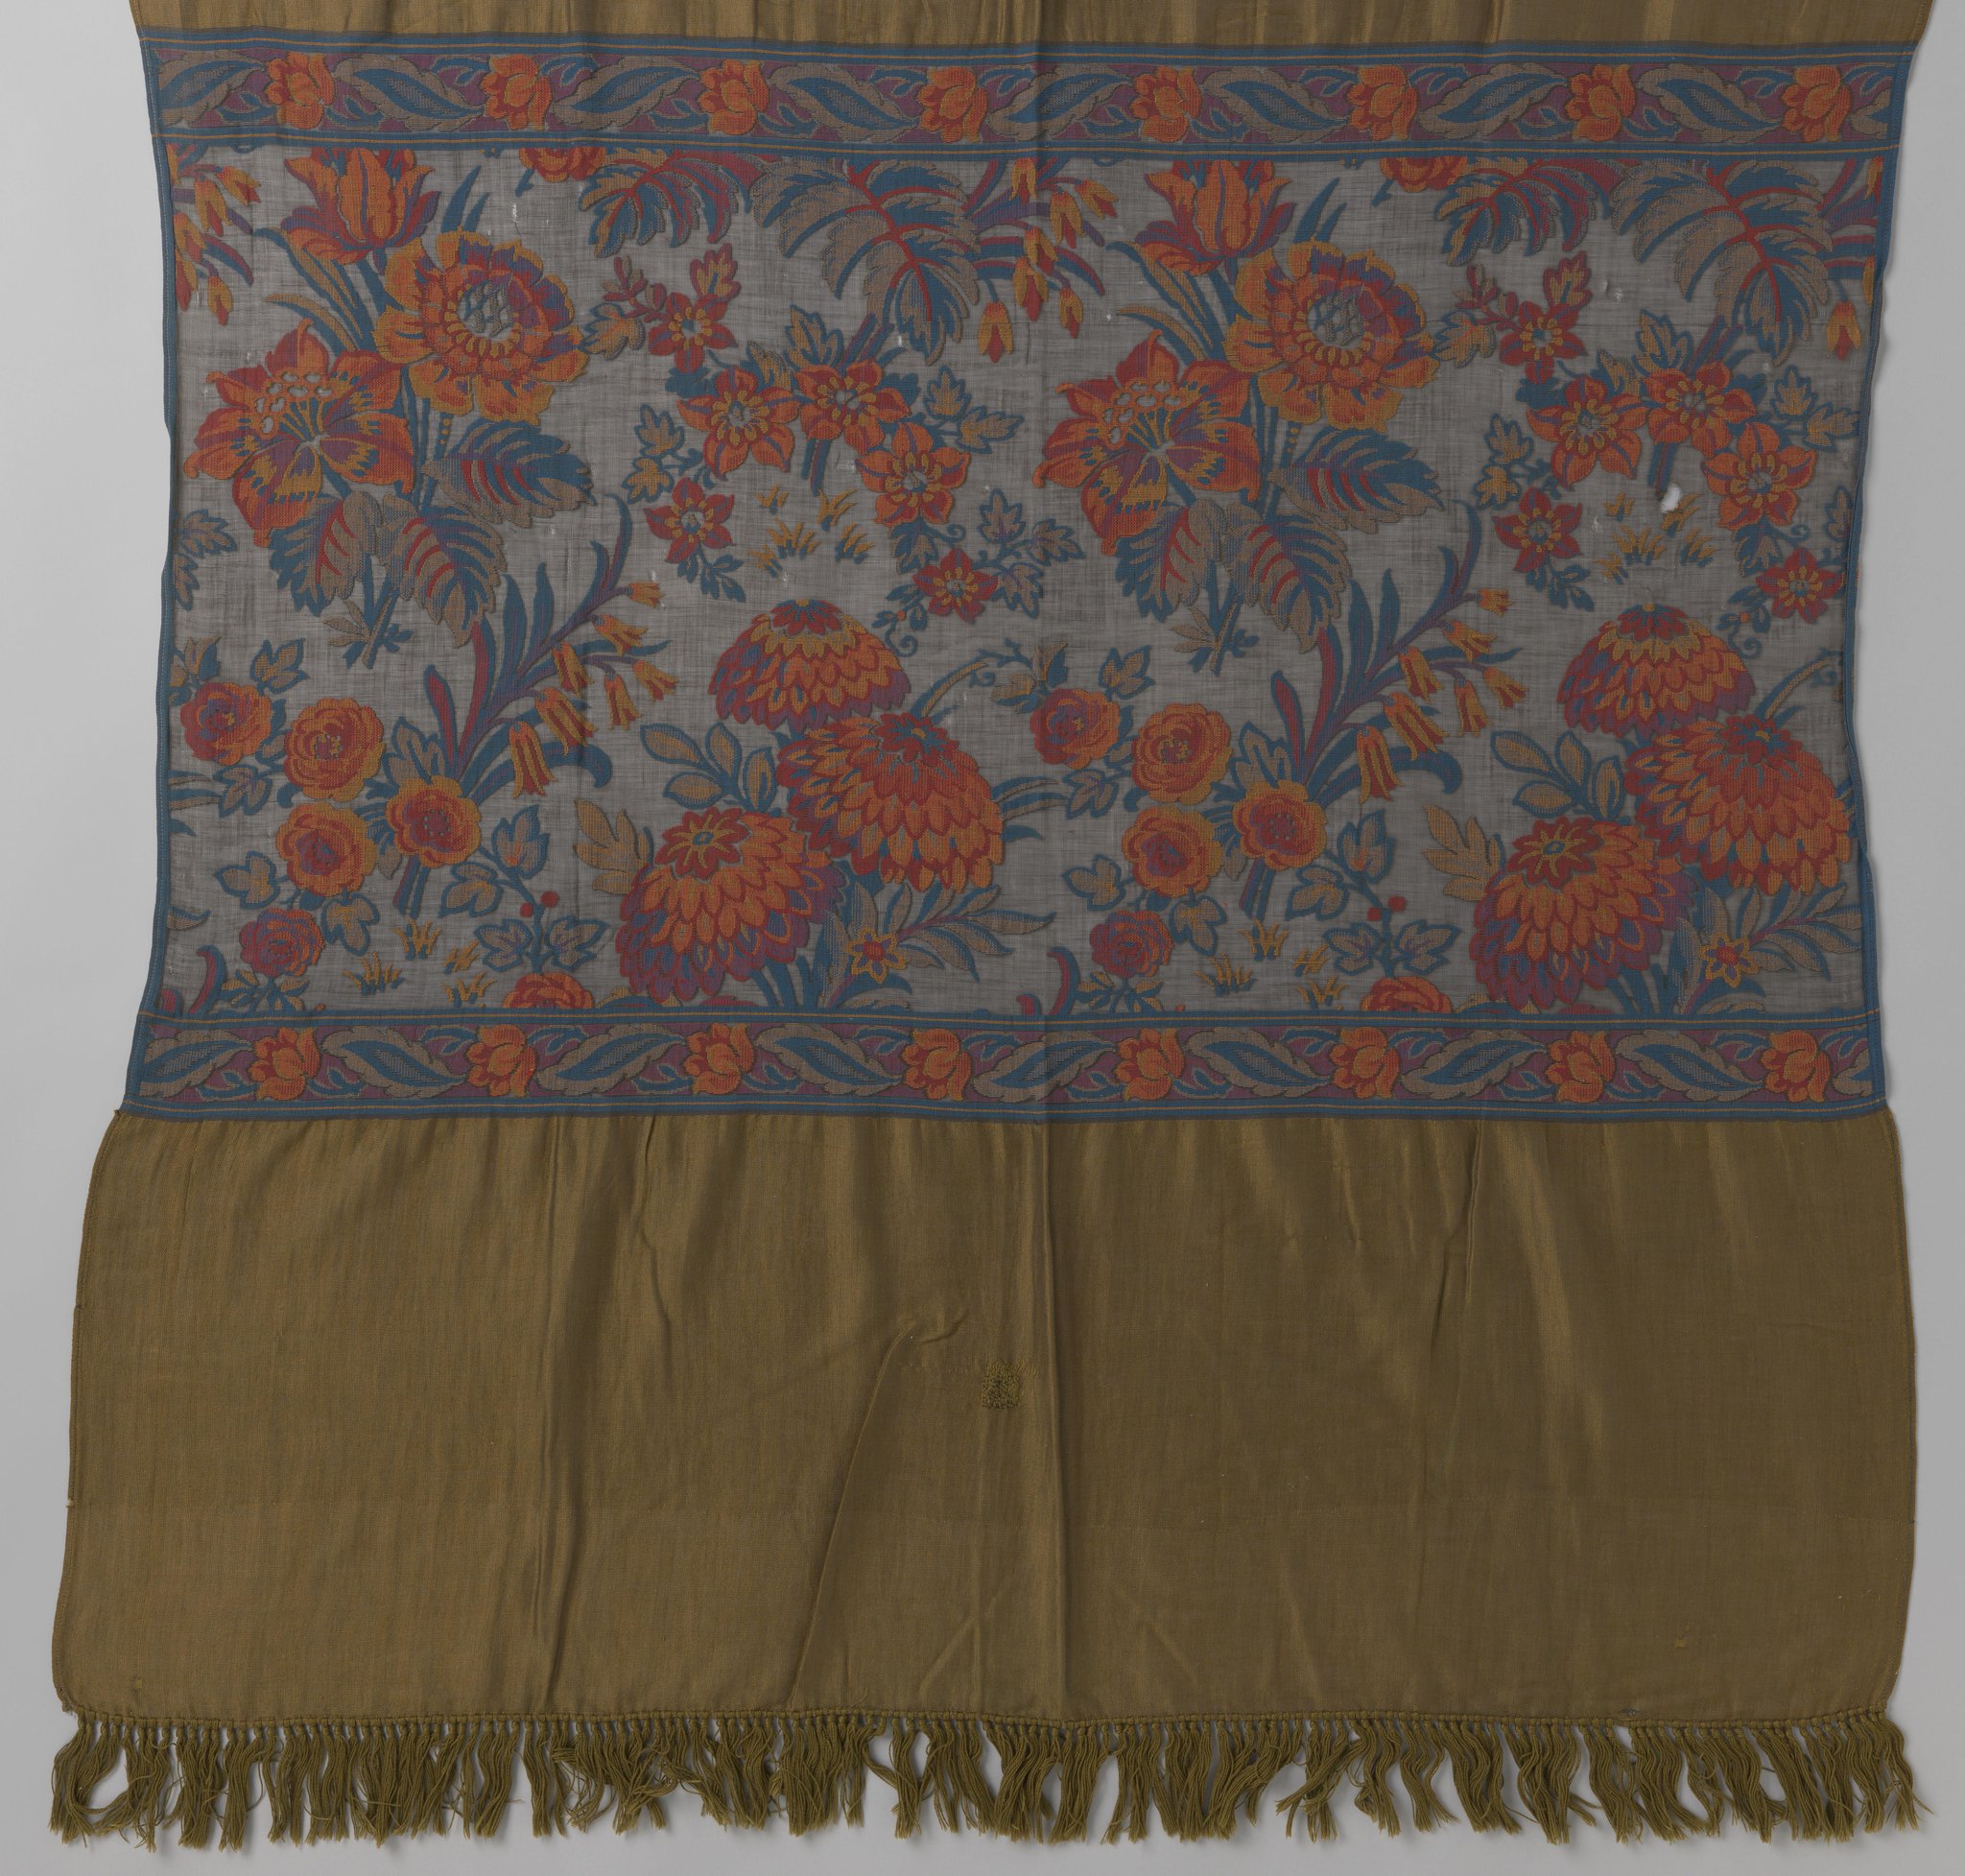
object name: curtain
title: Gordijn voor een serre in bronsgroen gaasweefsel, patroon "Madras".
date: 1920-1930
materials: textile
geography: ghent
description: Gordijn voor een serre patroon "Madras" in bronsgroen met twee horizontale banen in zwart gaasweefsel met ingeweven bloemen en bladeren in rood, oranje, geel en blauw. Onderaan afgeboord met franjes. Bovenaan zeven ophangringen aangenaaid.